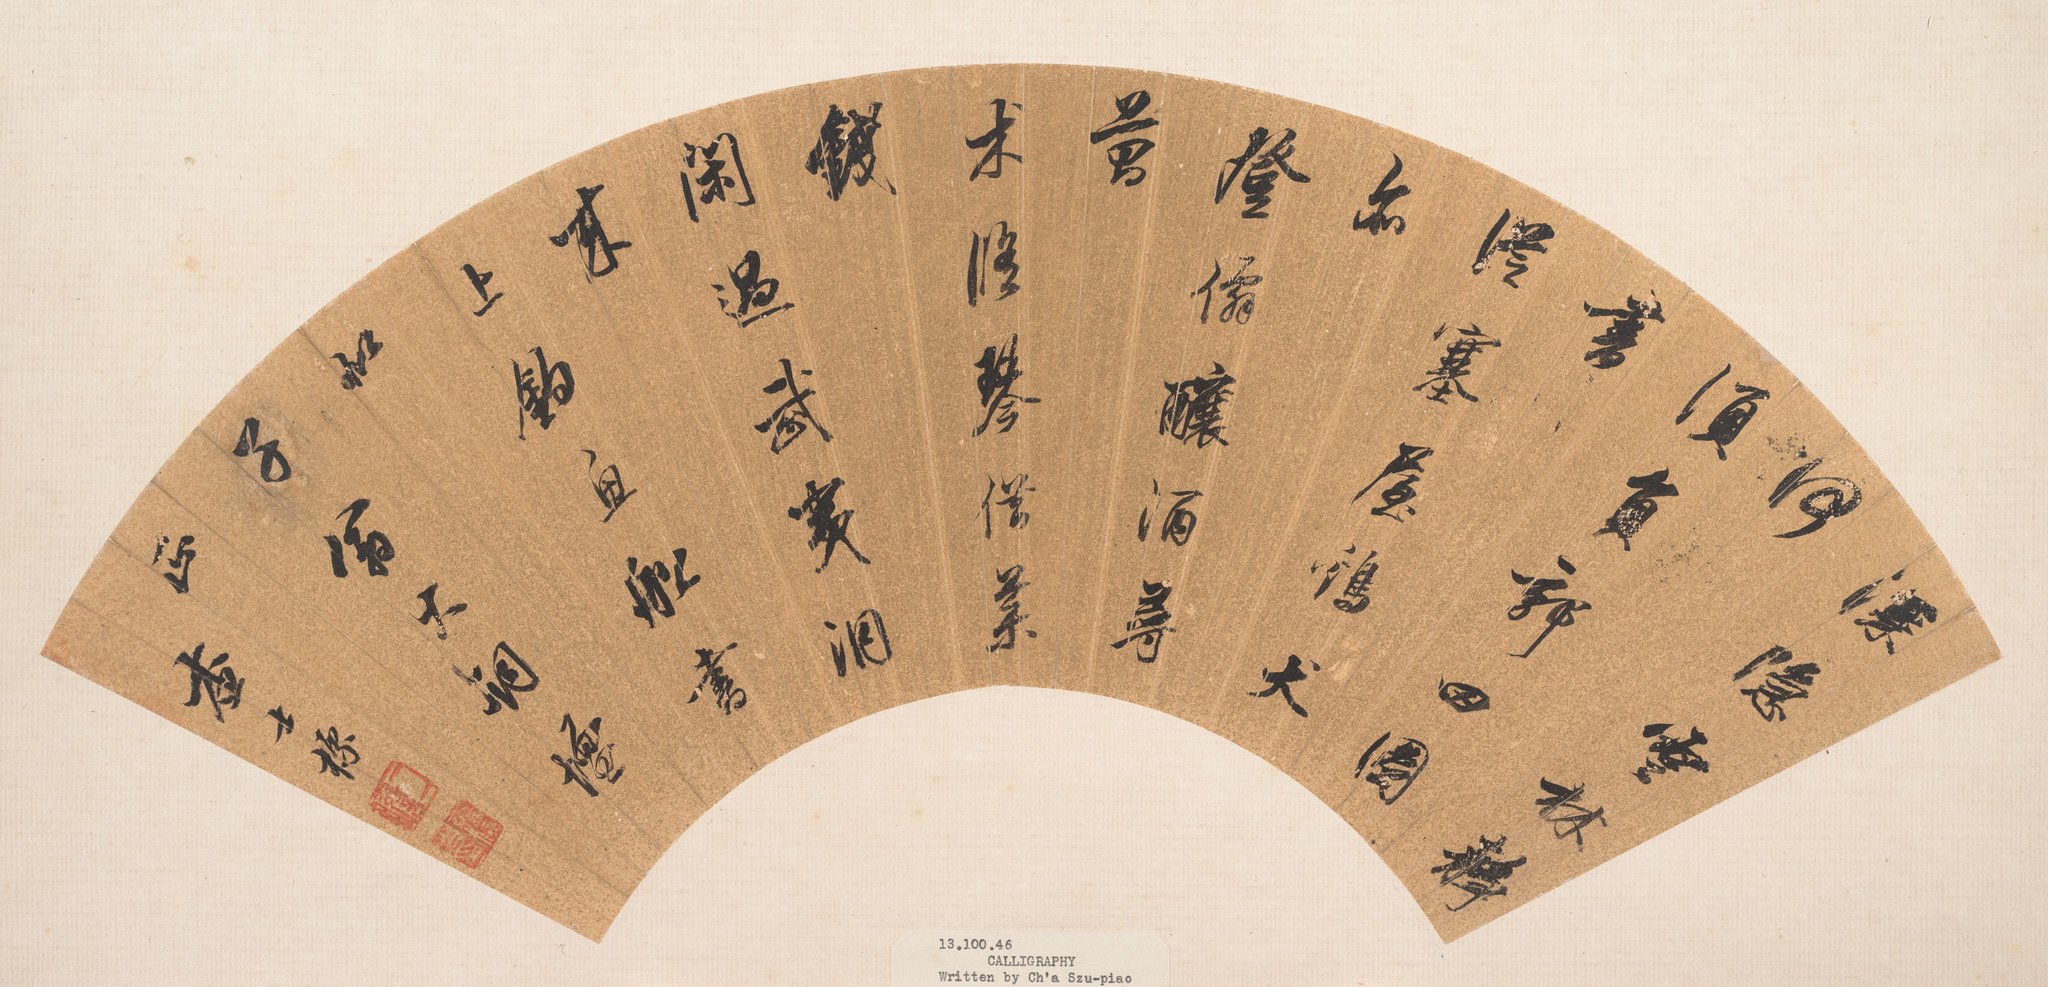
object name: folding fan mounted a an album leaf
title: Calligraphy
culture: chinese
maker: unidentified artist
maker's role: artist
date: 1701-1800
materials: ink, paper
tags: calligraphy